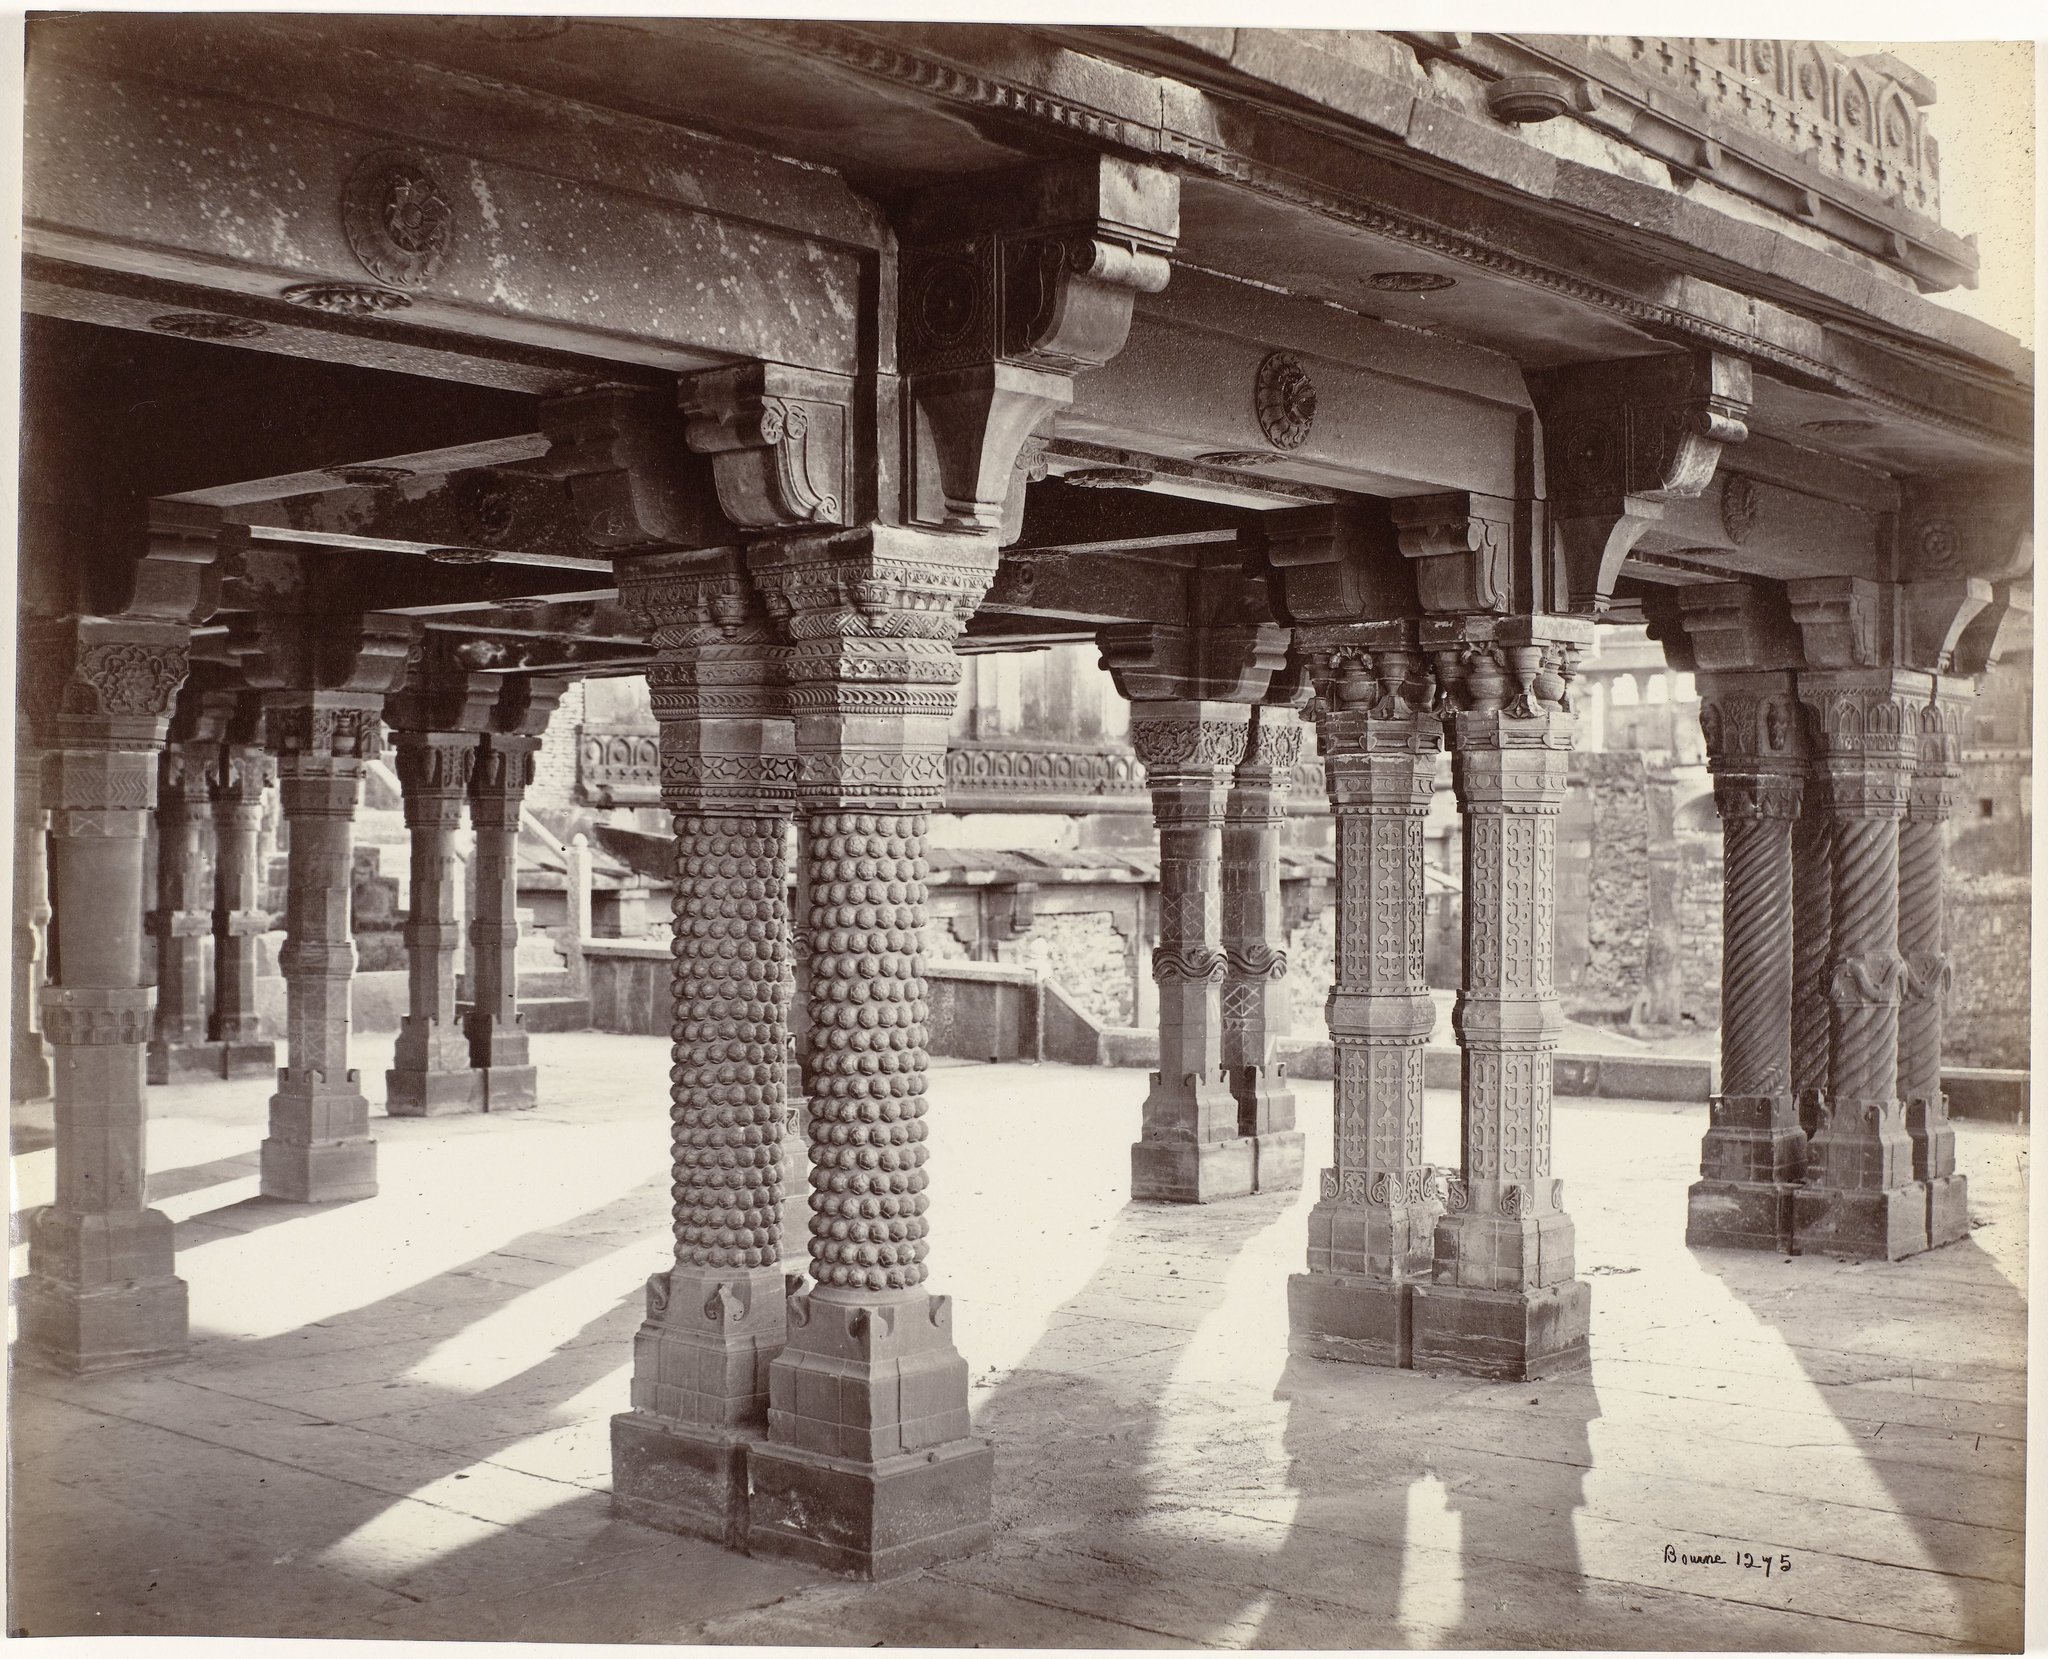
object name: photograph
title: Carved pillars of the Panch Mahal at Fatehpur Sikri, Uttar Pradesh, India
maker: samuel bourne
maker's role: fotograaf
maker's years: 1834-1912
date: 1863-1865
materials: paper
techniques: albumen print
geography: fatehpur sikri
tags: column, pillar ~ architecture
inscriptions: name: ‘Bourne’, number: ‘1275’, inscription: ‘1275/ Futtipore Sikri/ Carved pillars in Panch Mehal’